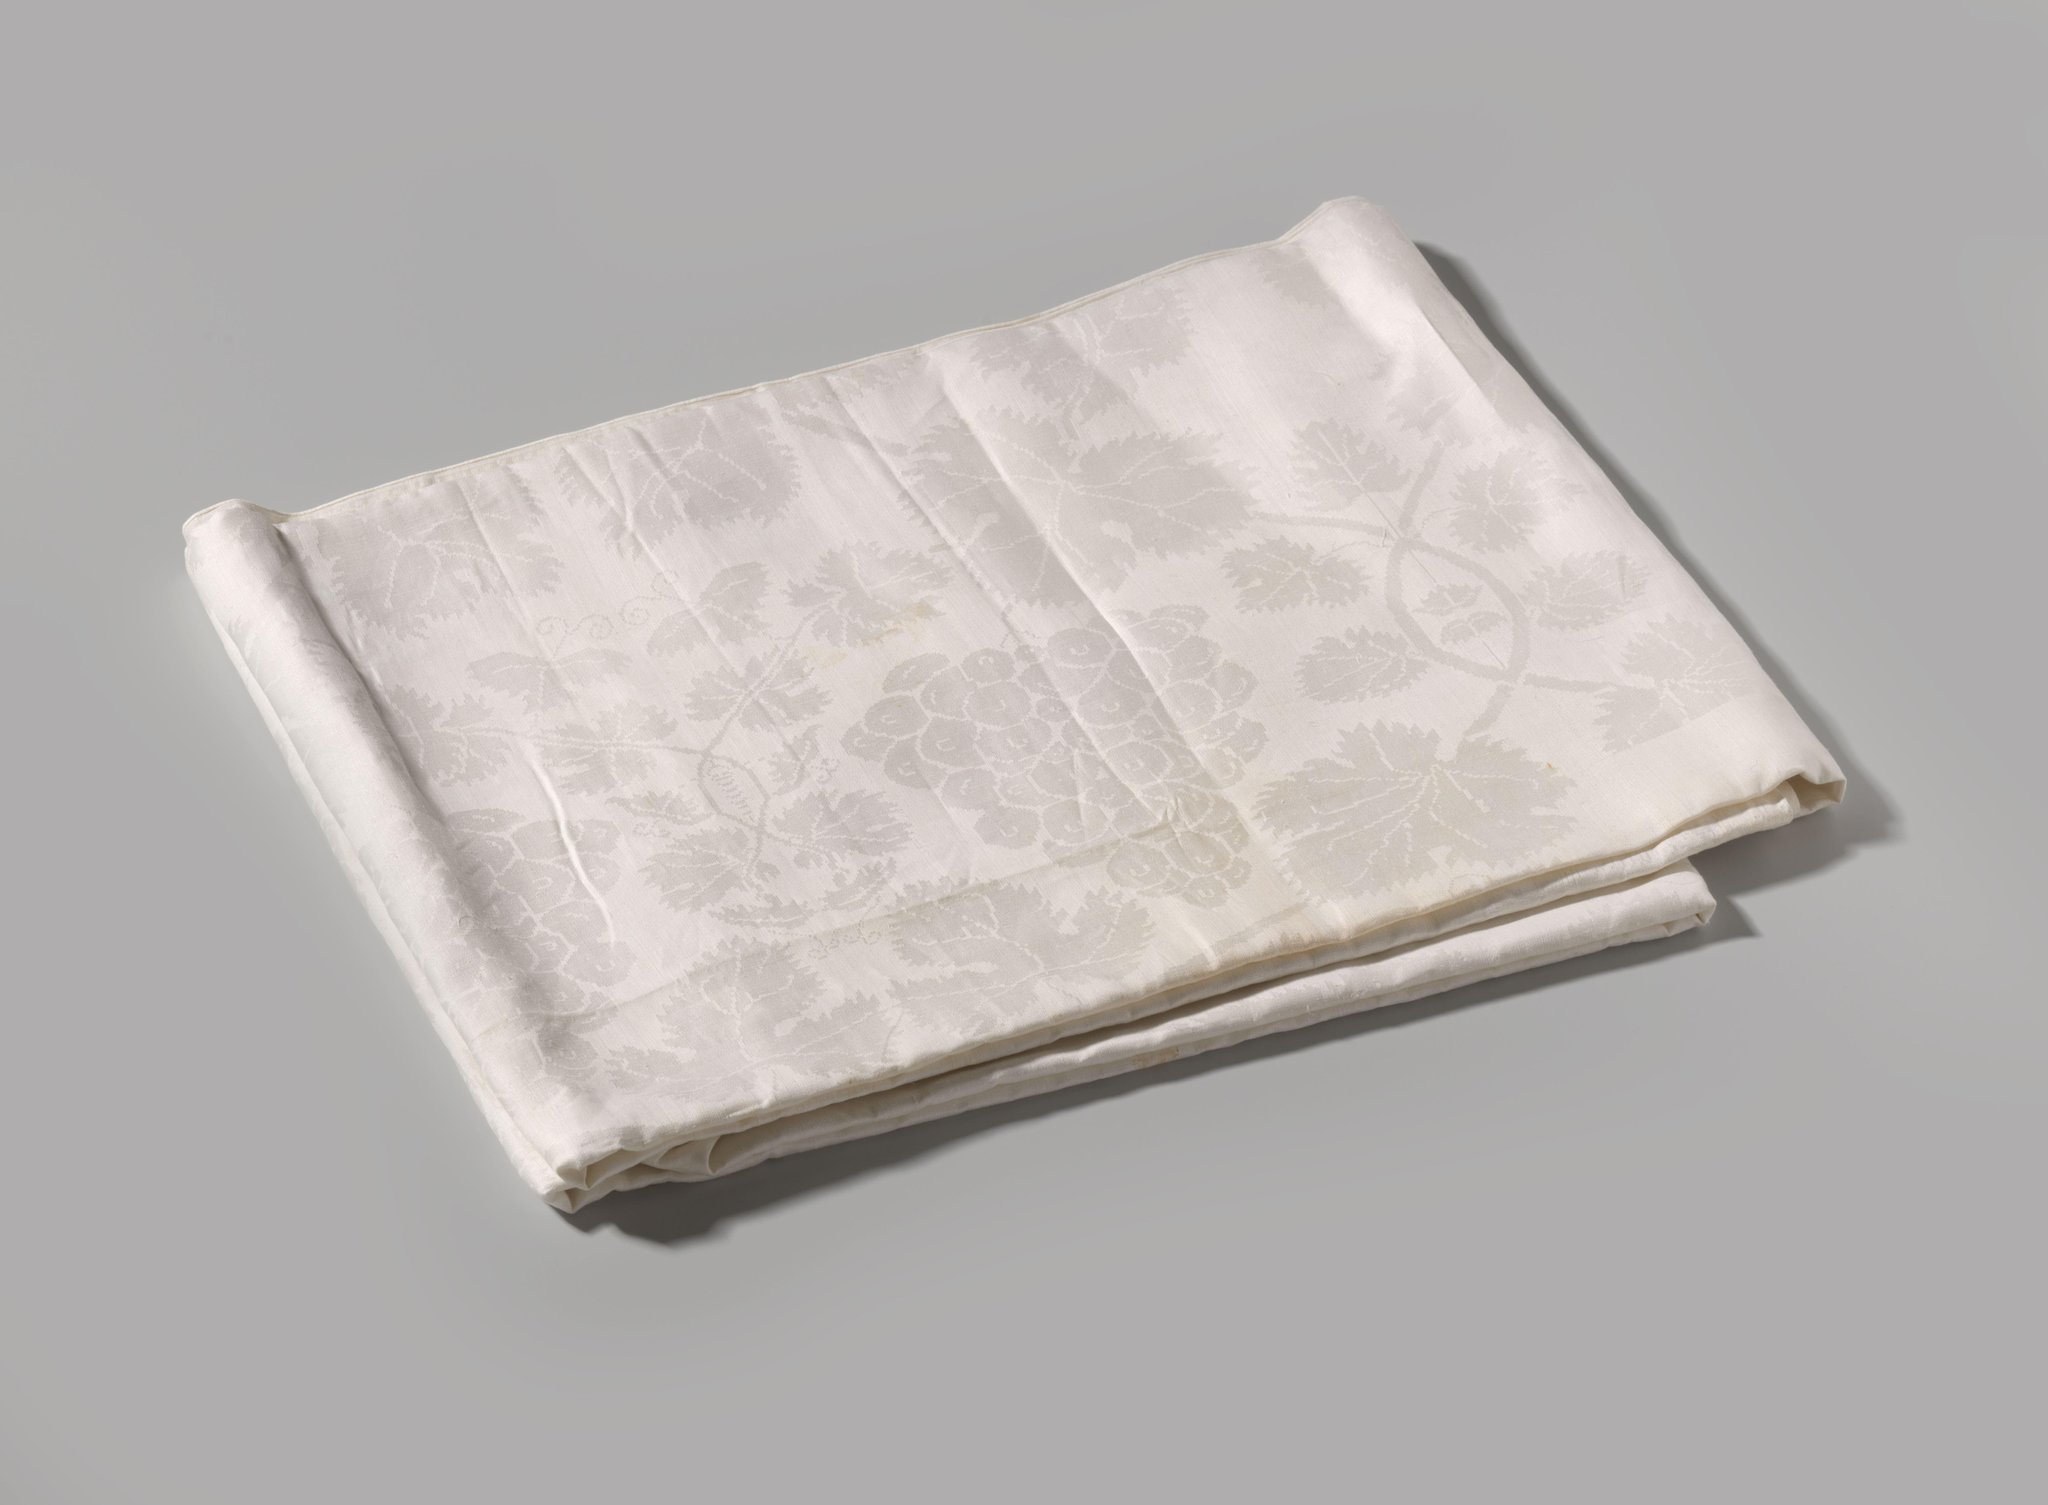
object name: tablecloth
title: Tafellaken van linnendamast met wapens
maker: Anonymous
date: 1682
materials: linen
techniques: damask, weave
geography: northern netherlands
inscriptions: mark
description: Wit linnen damasten tafellaken met druivenranken en het wapen Nassau-Van Beijeren Schagen en ingeweven de datering 1682.